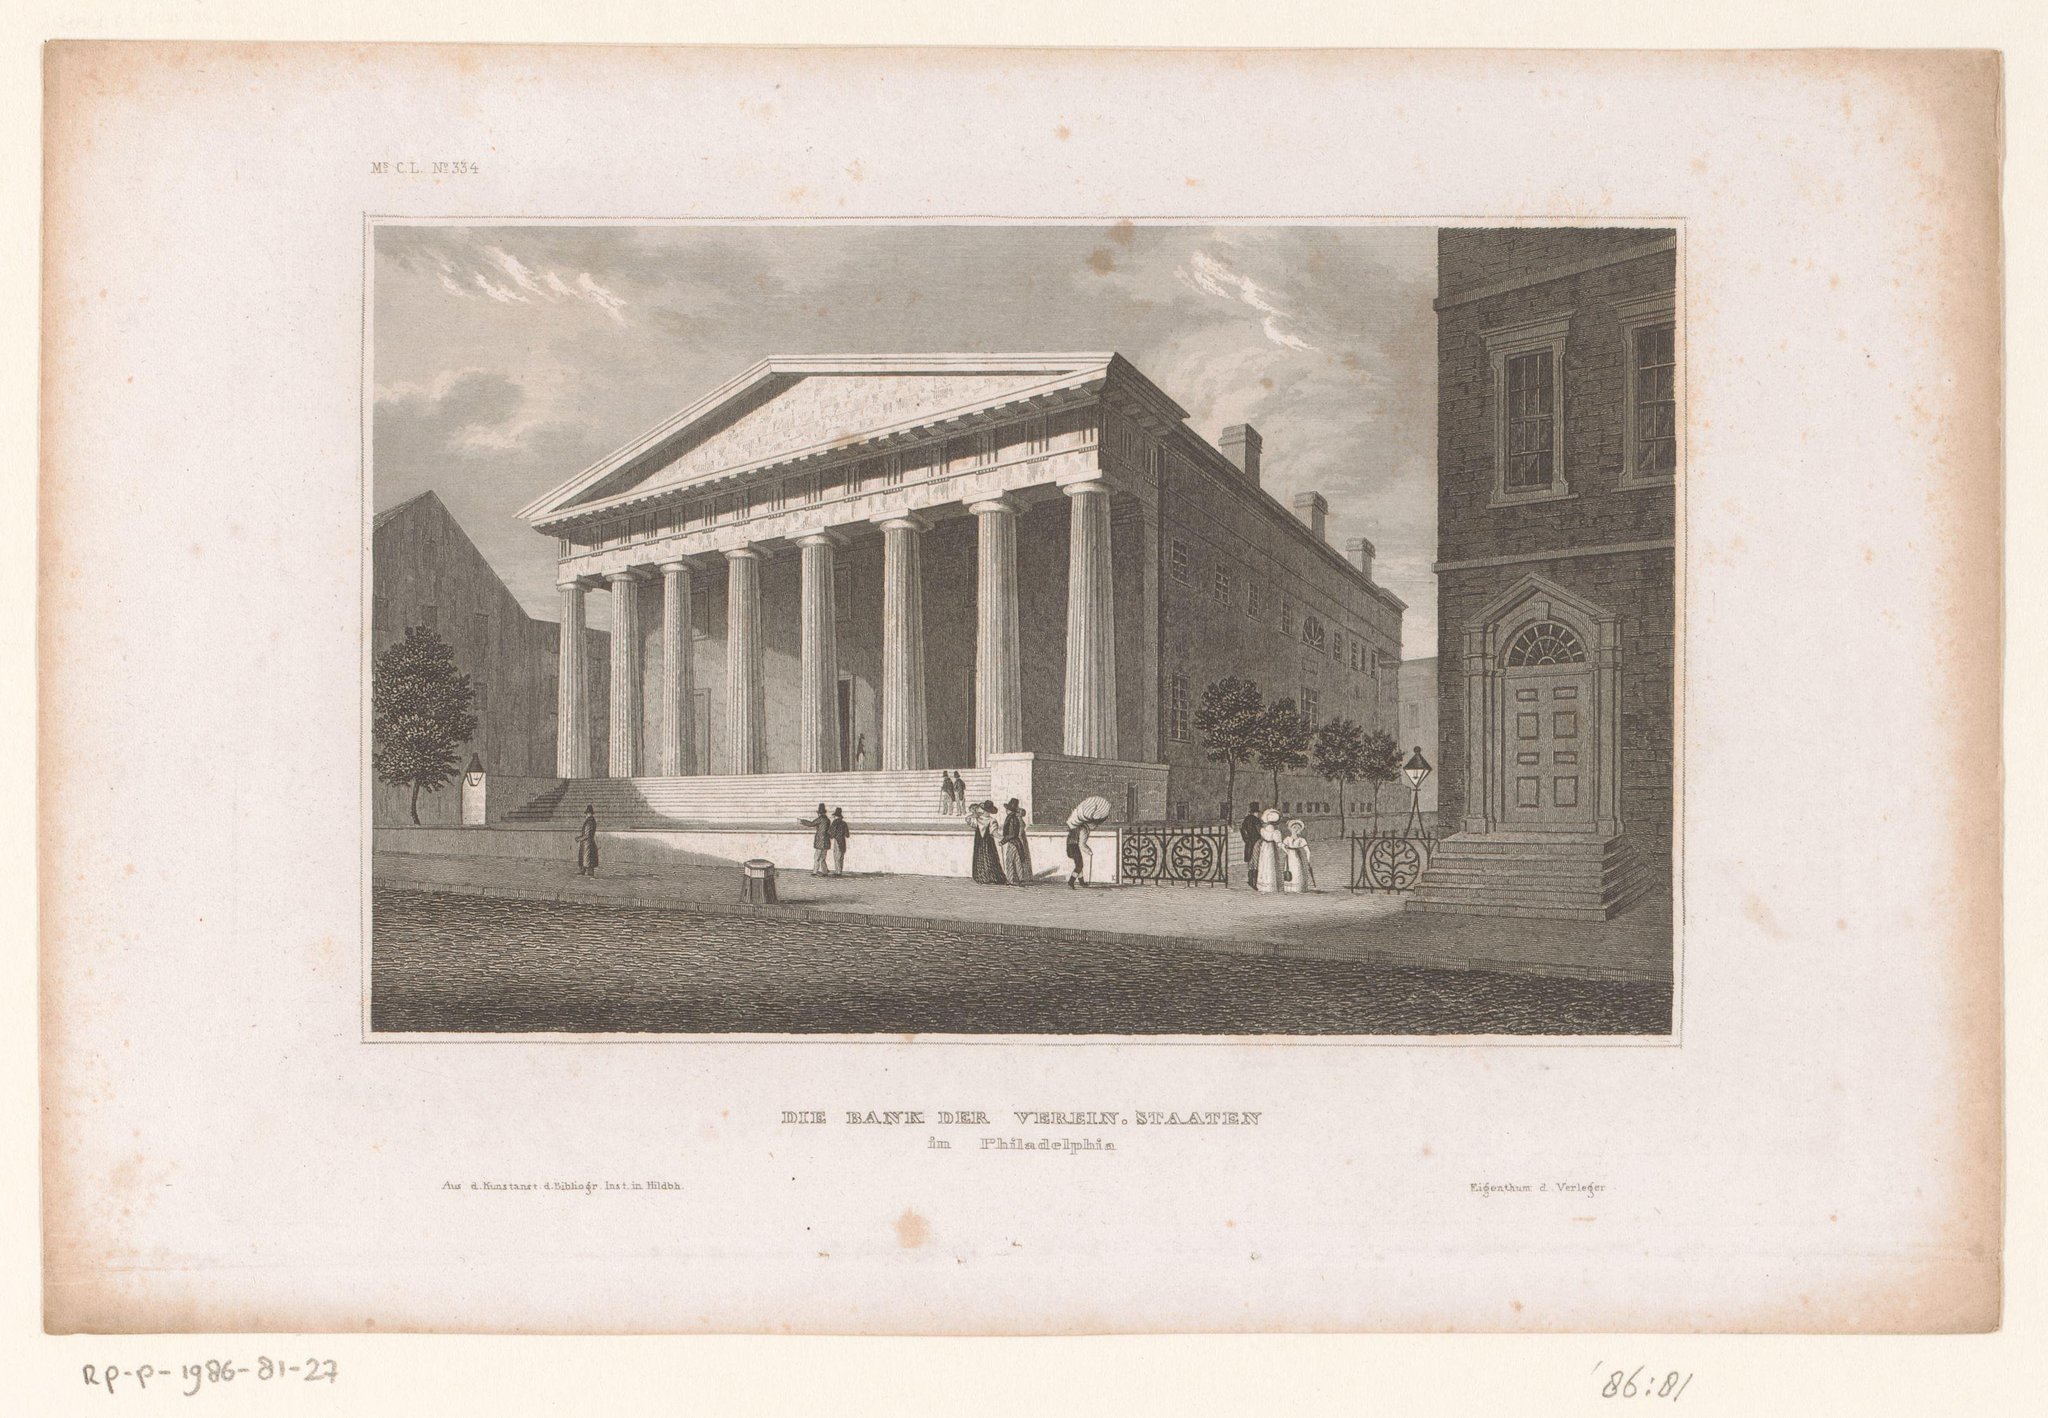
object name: print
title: Bank van de Verenigde Staten in Philadelphia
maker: Anonymous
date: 1835-1863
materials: paper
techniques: engraving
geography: hildburghausen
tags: bank, street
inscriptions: collector's mark: Lugt 2760, collector's mark: Lugt 2228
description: Prent verschenen in: Meyer, Joseph. Meyer's Universum. Hildburghausen: Bibliographisches Institut, 1835-1863.